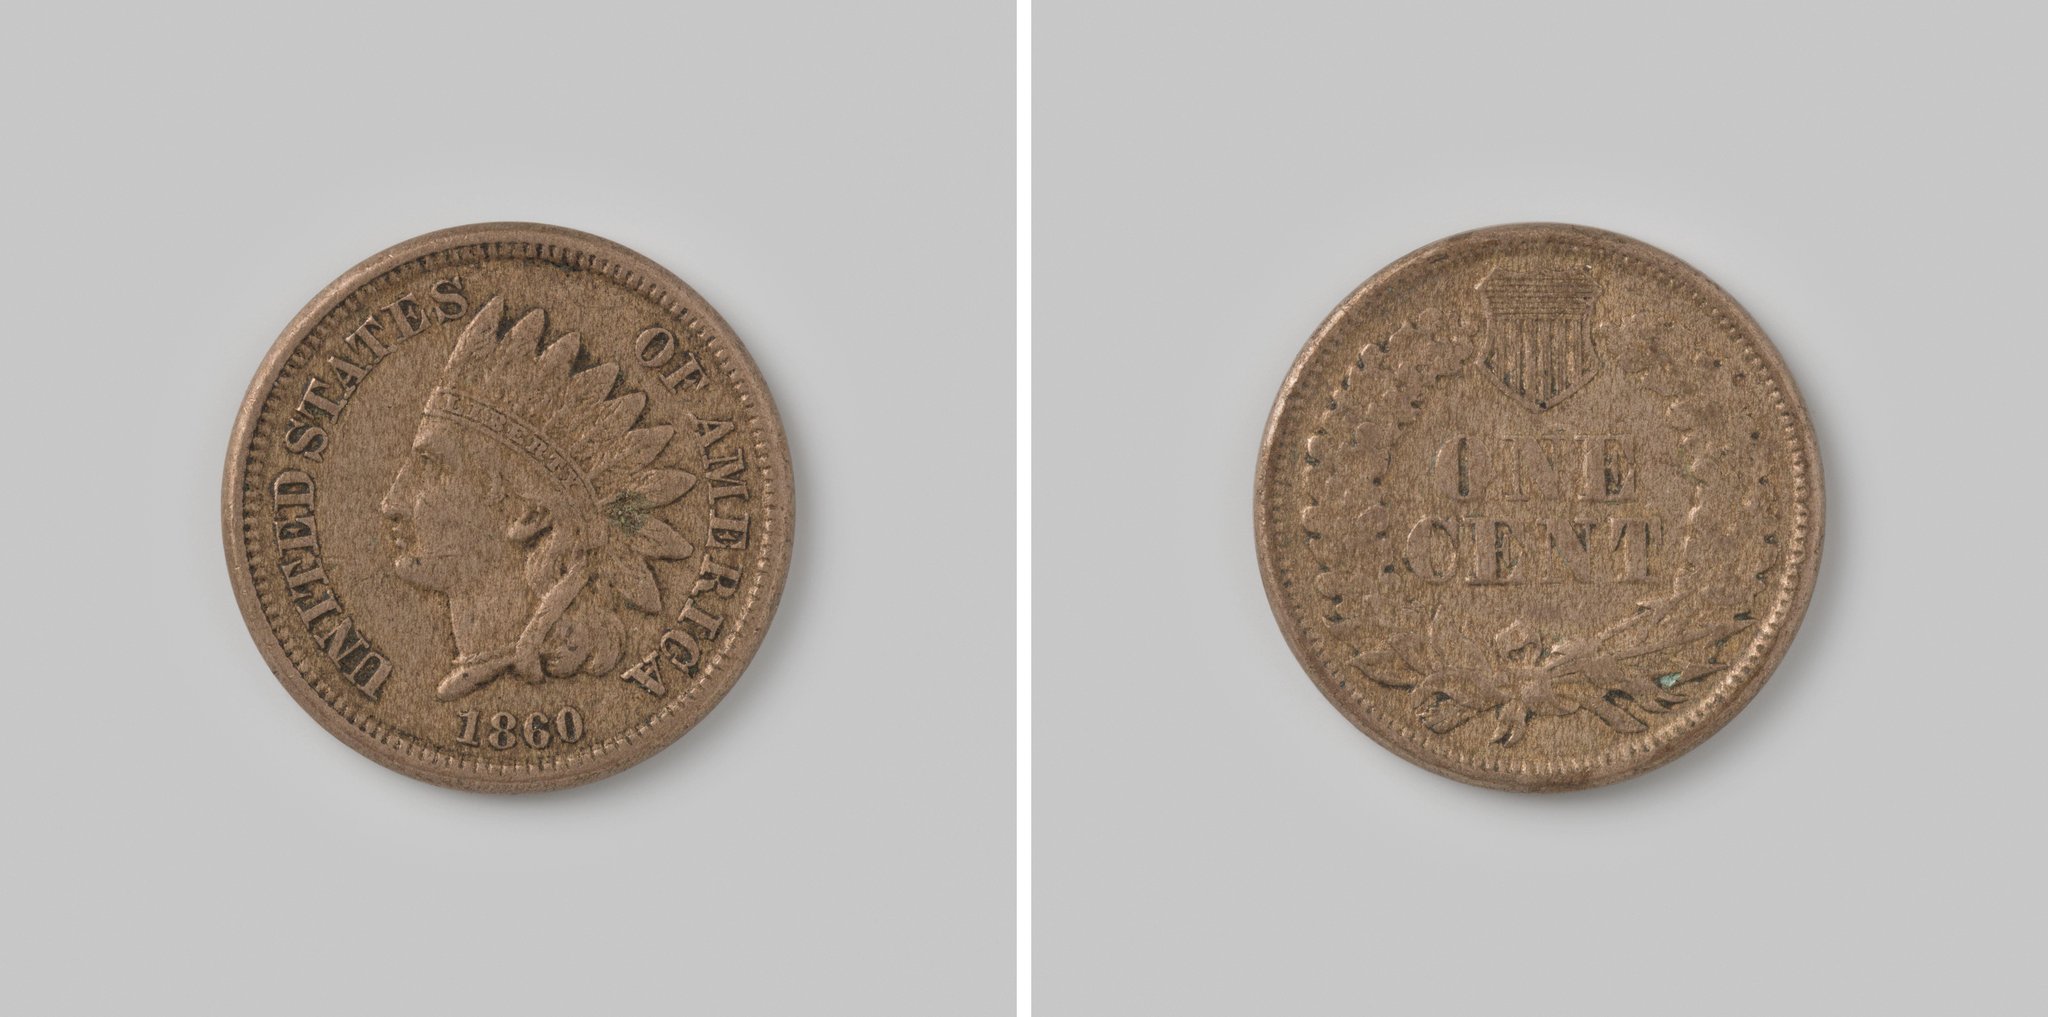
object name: coin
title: Cent uit de Verenigde Staten van Amerika, 1860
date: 1860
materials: nickel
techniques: striking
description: Koper-nikkelen munt. Voorzijde: hoofd met Indianentooi (Indian head) naar links. Jaartal onderaan. Keerzijde: tussen twee samengebonden takken wapenschild, waaronder waarde-aanduiding: one cent in twee regels. Gladde rand.